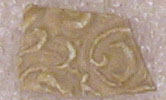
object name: fragment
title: Ceramic Fragment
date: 701-900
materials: earthenware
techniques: molding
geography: iraq